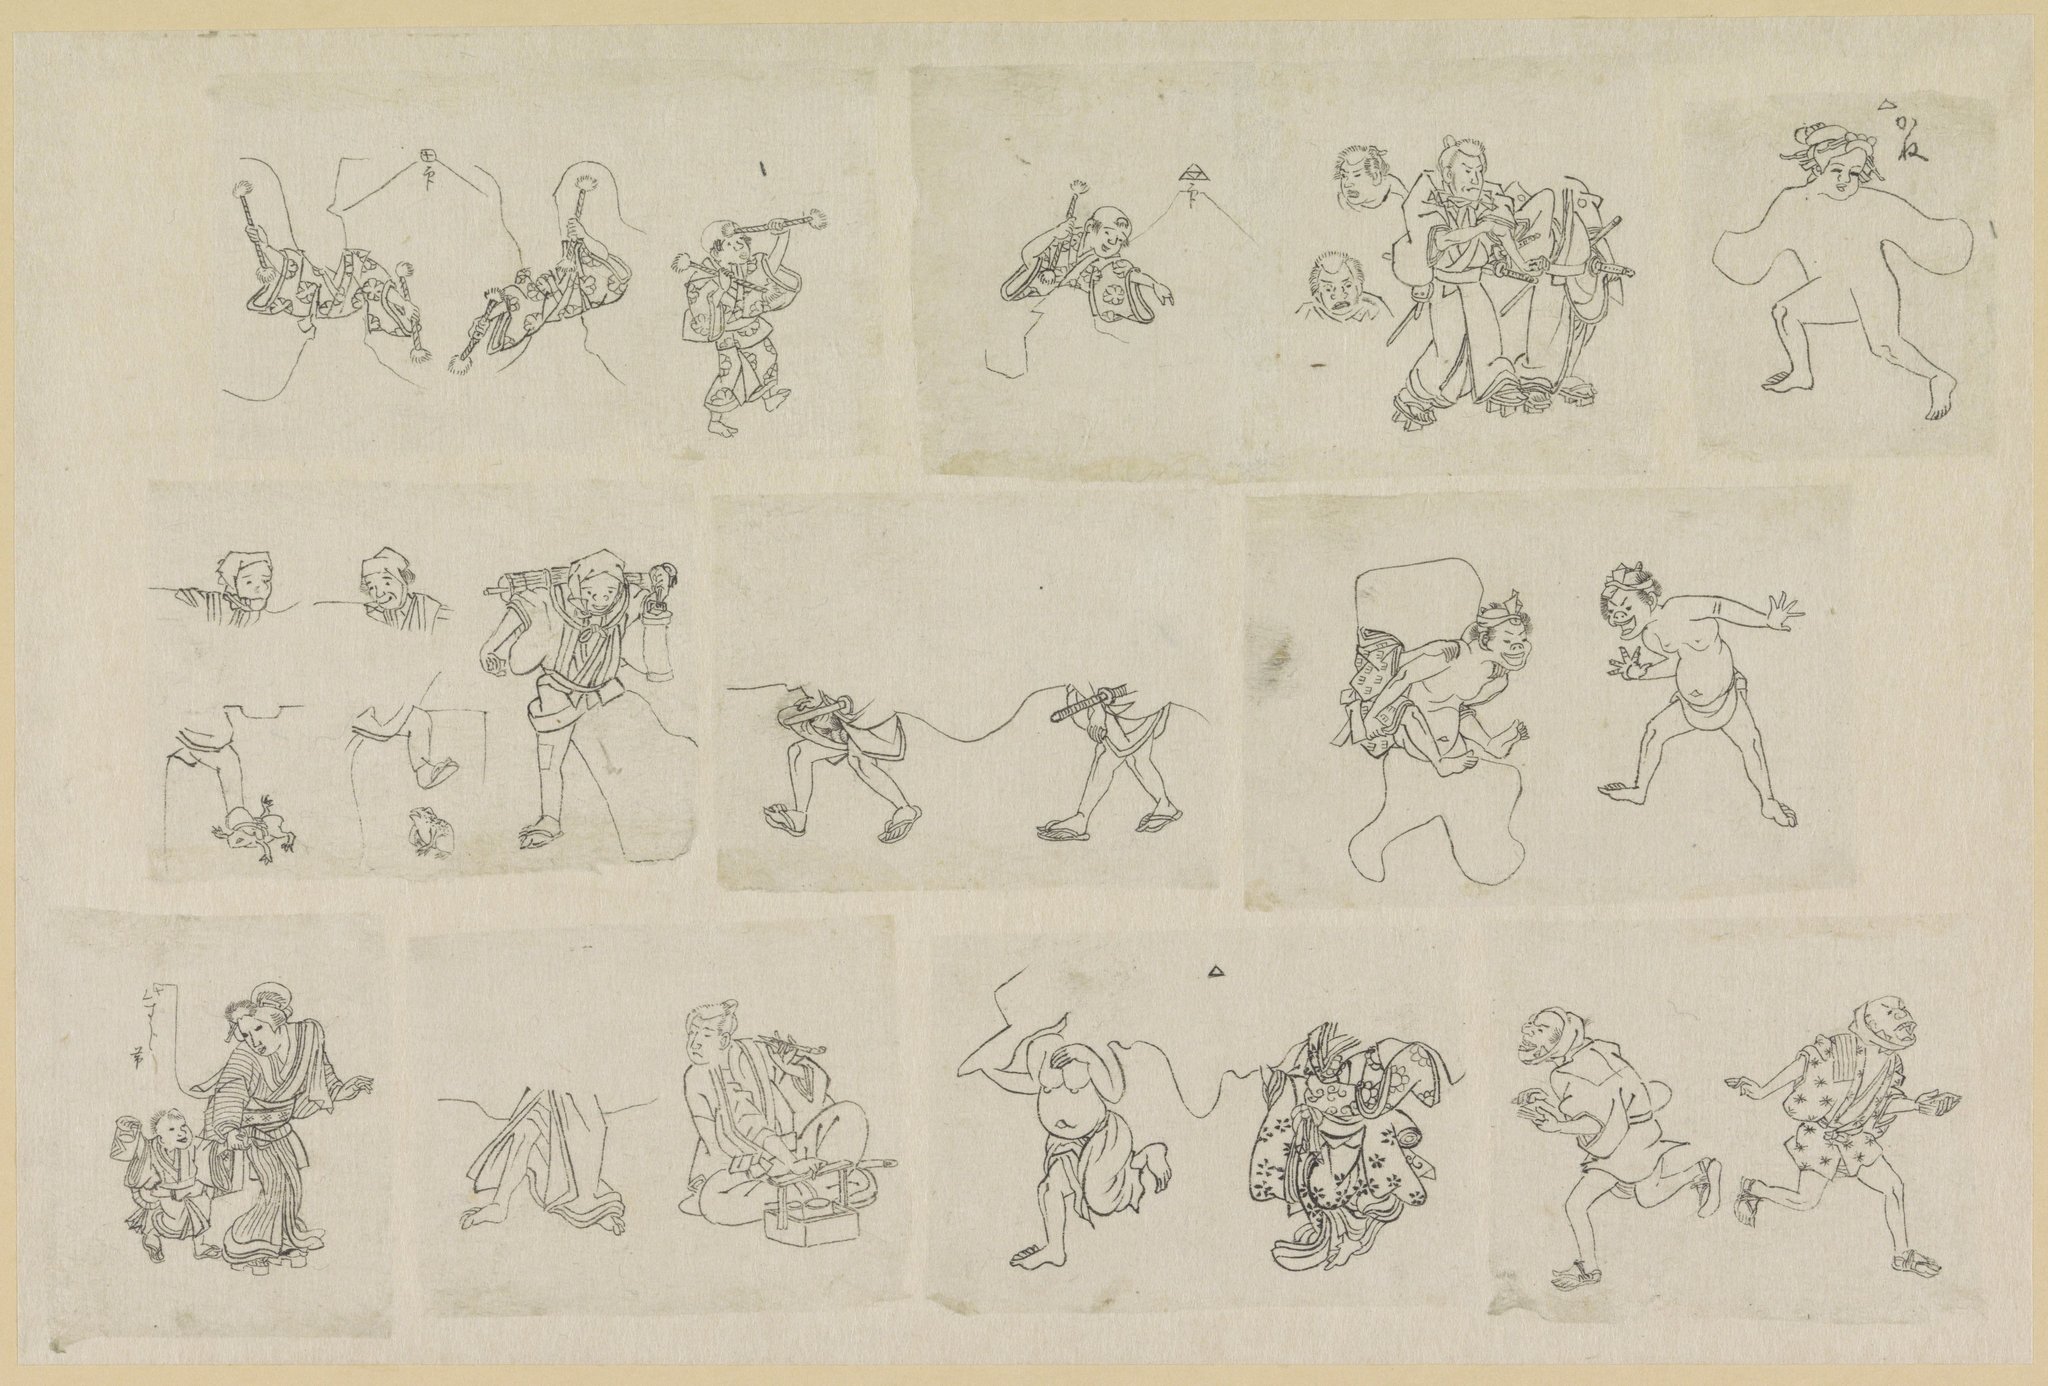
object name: drawing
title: Elf verschillende voorstellingen van mensen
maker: katsushika hokusai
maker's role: draughtsman, print maker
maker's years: 1760-1849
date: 1800-1900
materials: ink, paper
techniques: pen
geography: japan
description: Blad met elf opgeplakte tekeningen van verschillende mensen, waaronder een rokende man, een man die een kikker dood trapt en een vrouw met een kind aan de hand.